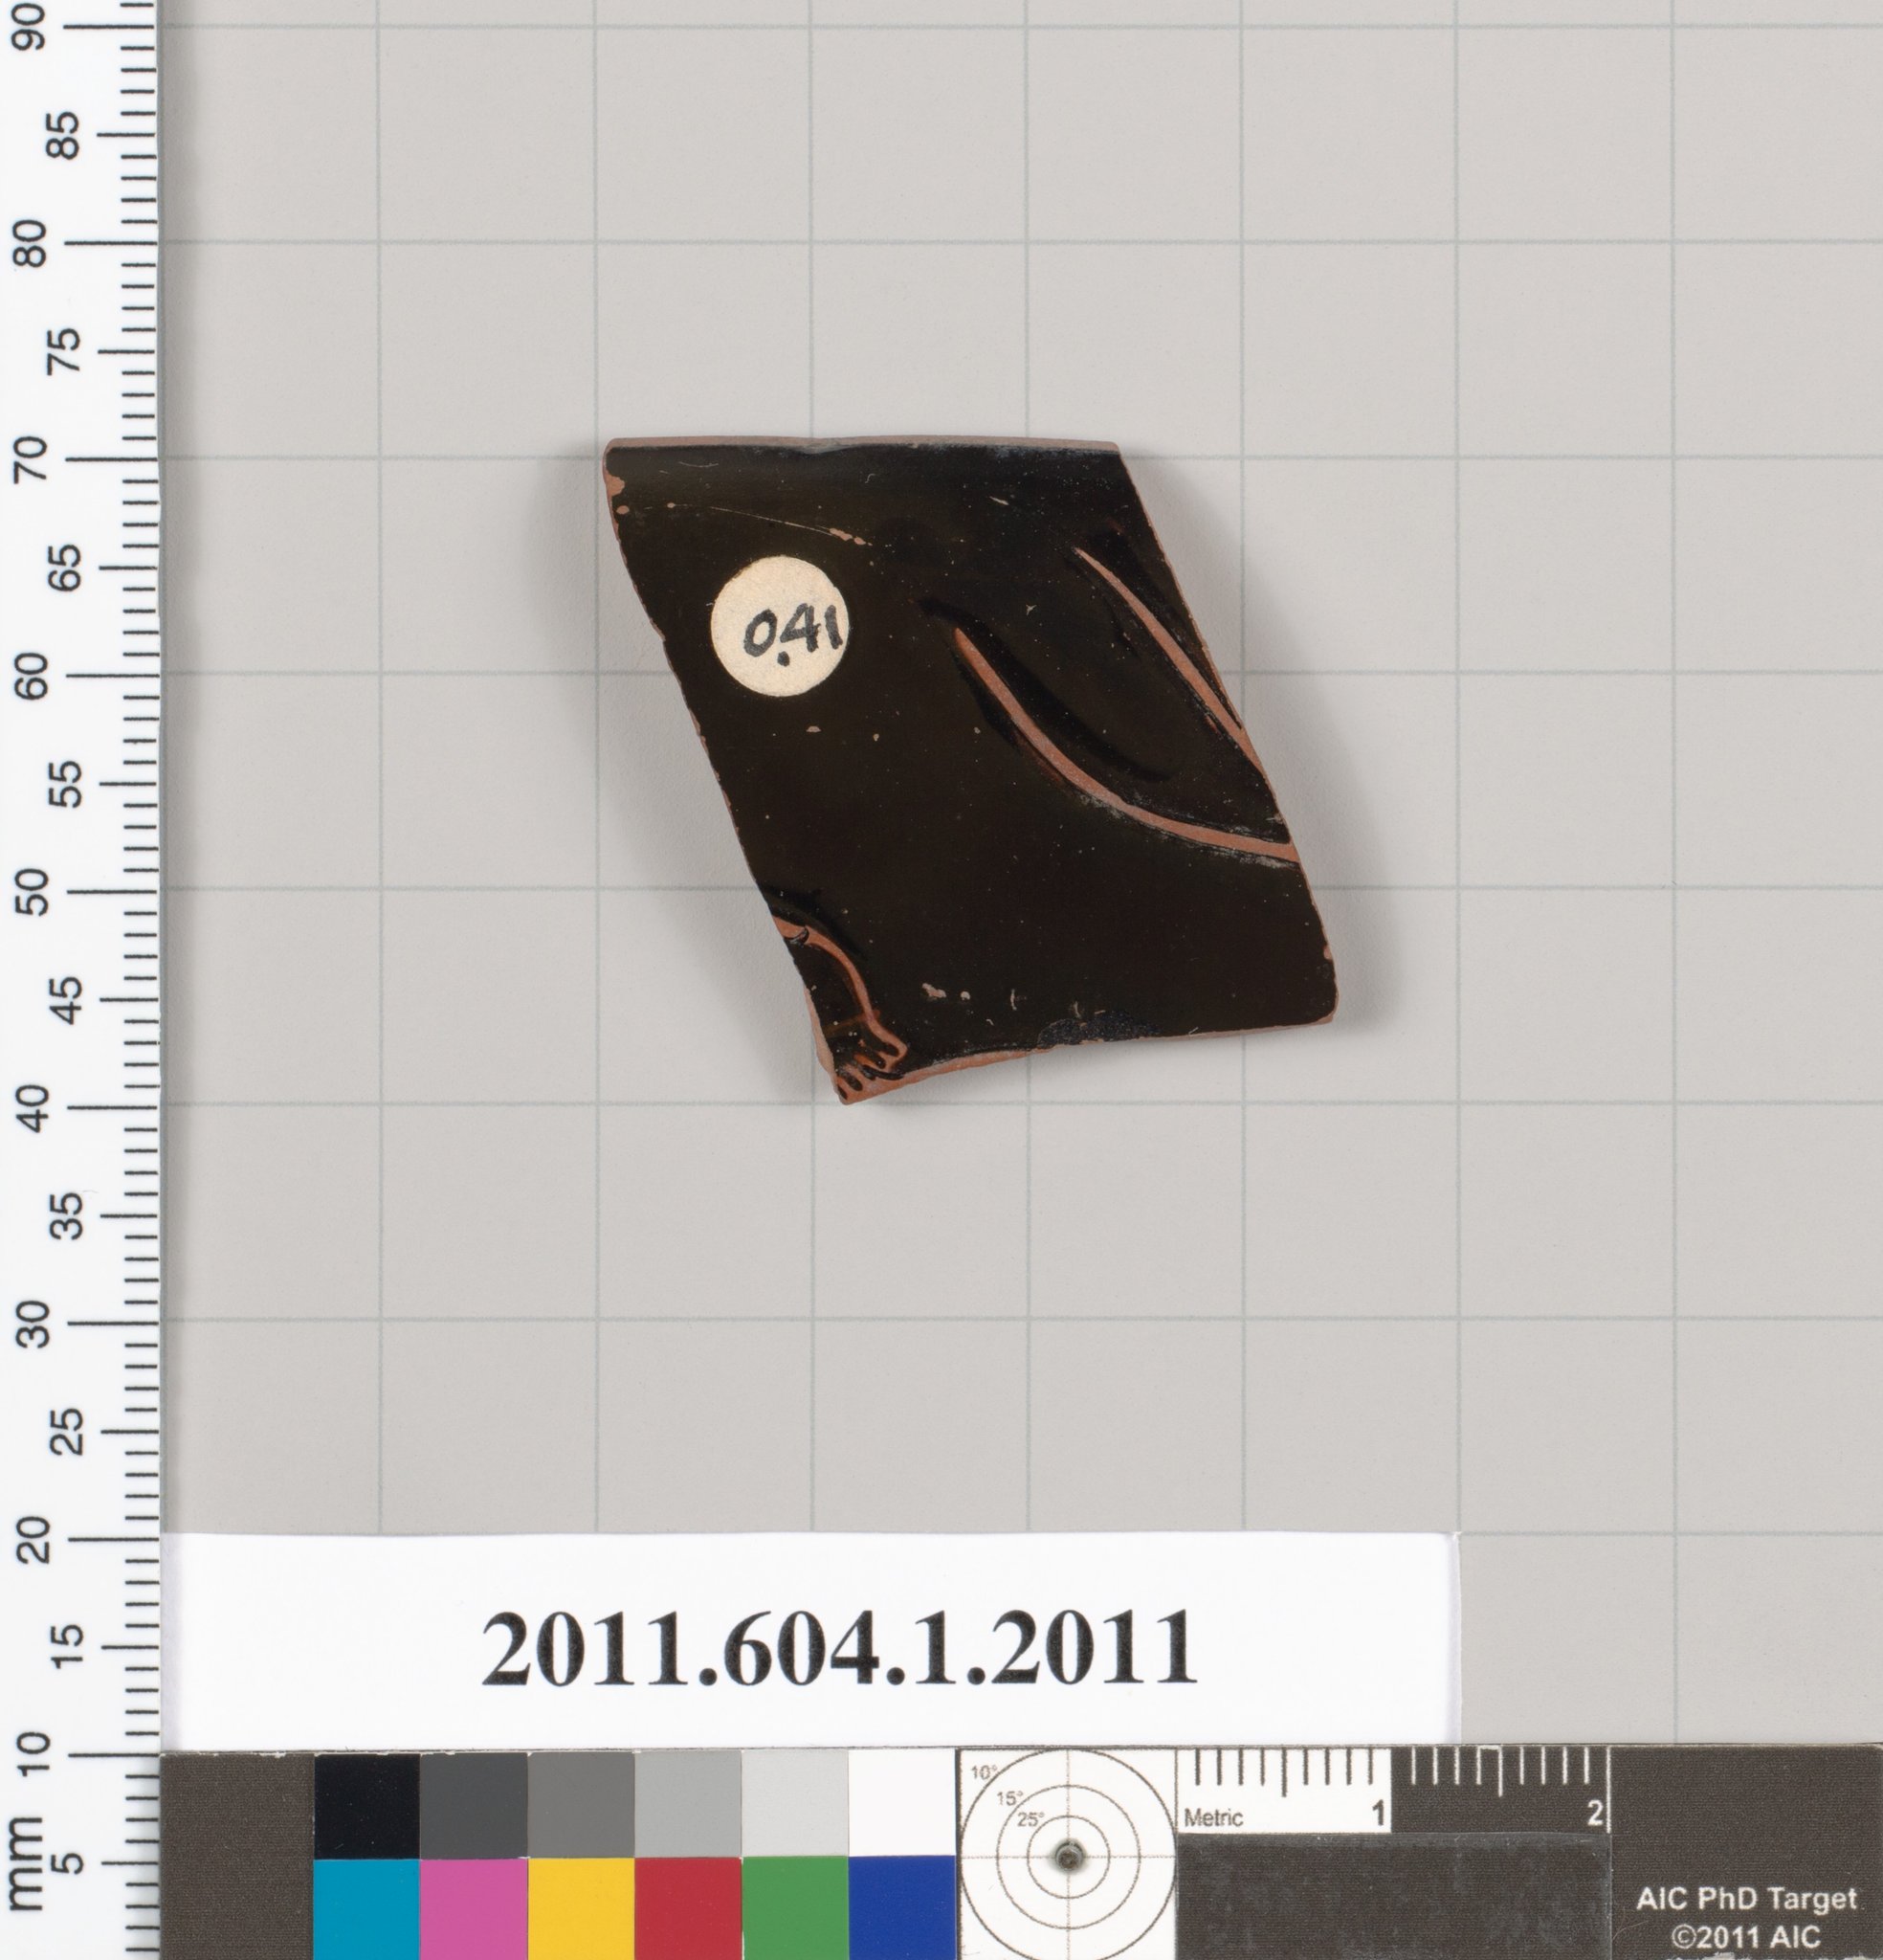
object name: kylix fragment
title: Terracotta rim fragment of a kylix (drinking cup)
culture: greek, attic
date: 475-451 BCE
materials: terracotta